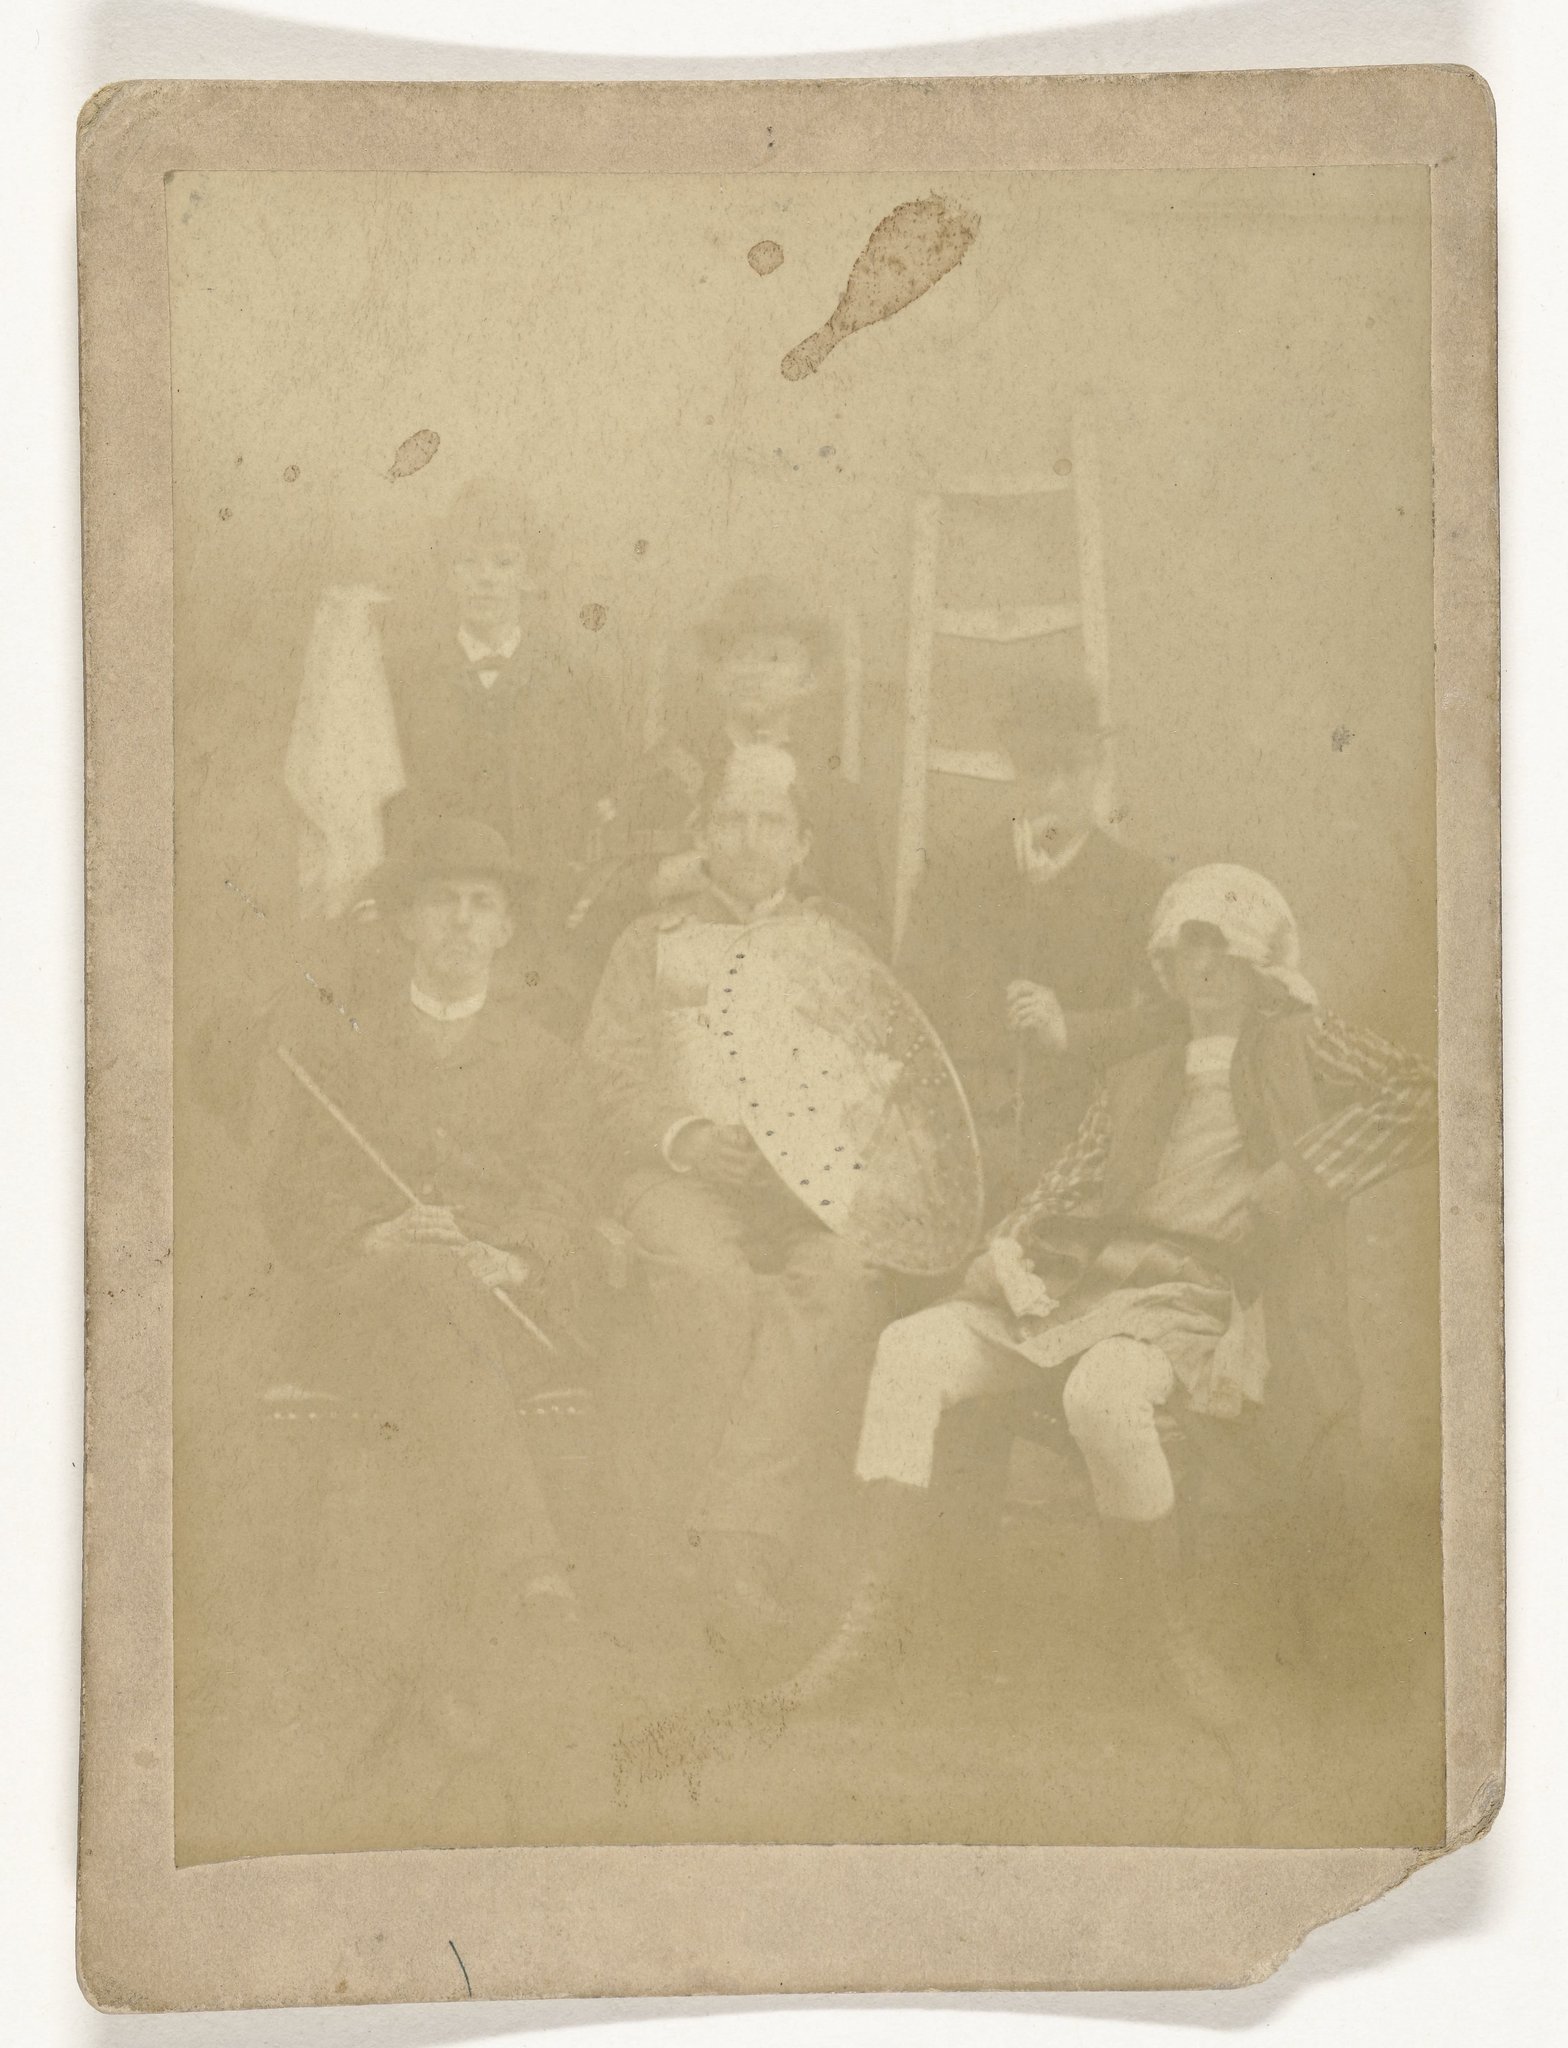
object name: photograph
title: Studenten Leiden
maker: israël david kiek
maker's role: fotograaf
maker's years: 1811-1899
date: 1887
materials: cardboard, paper, photographic support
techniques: albumen print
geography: netherlands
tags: anonymous historical persons portrayed in a group, in a group-portrait, leiden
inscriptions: annotation: ‘studenten Leiden’